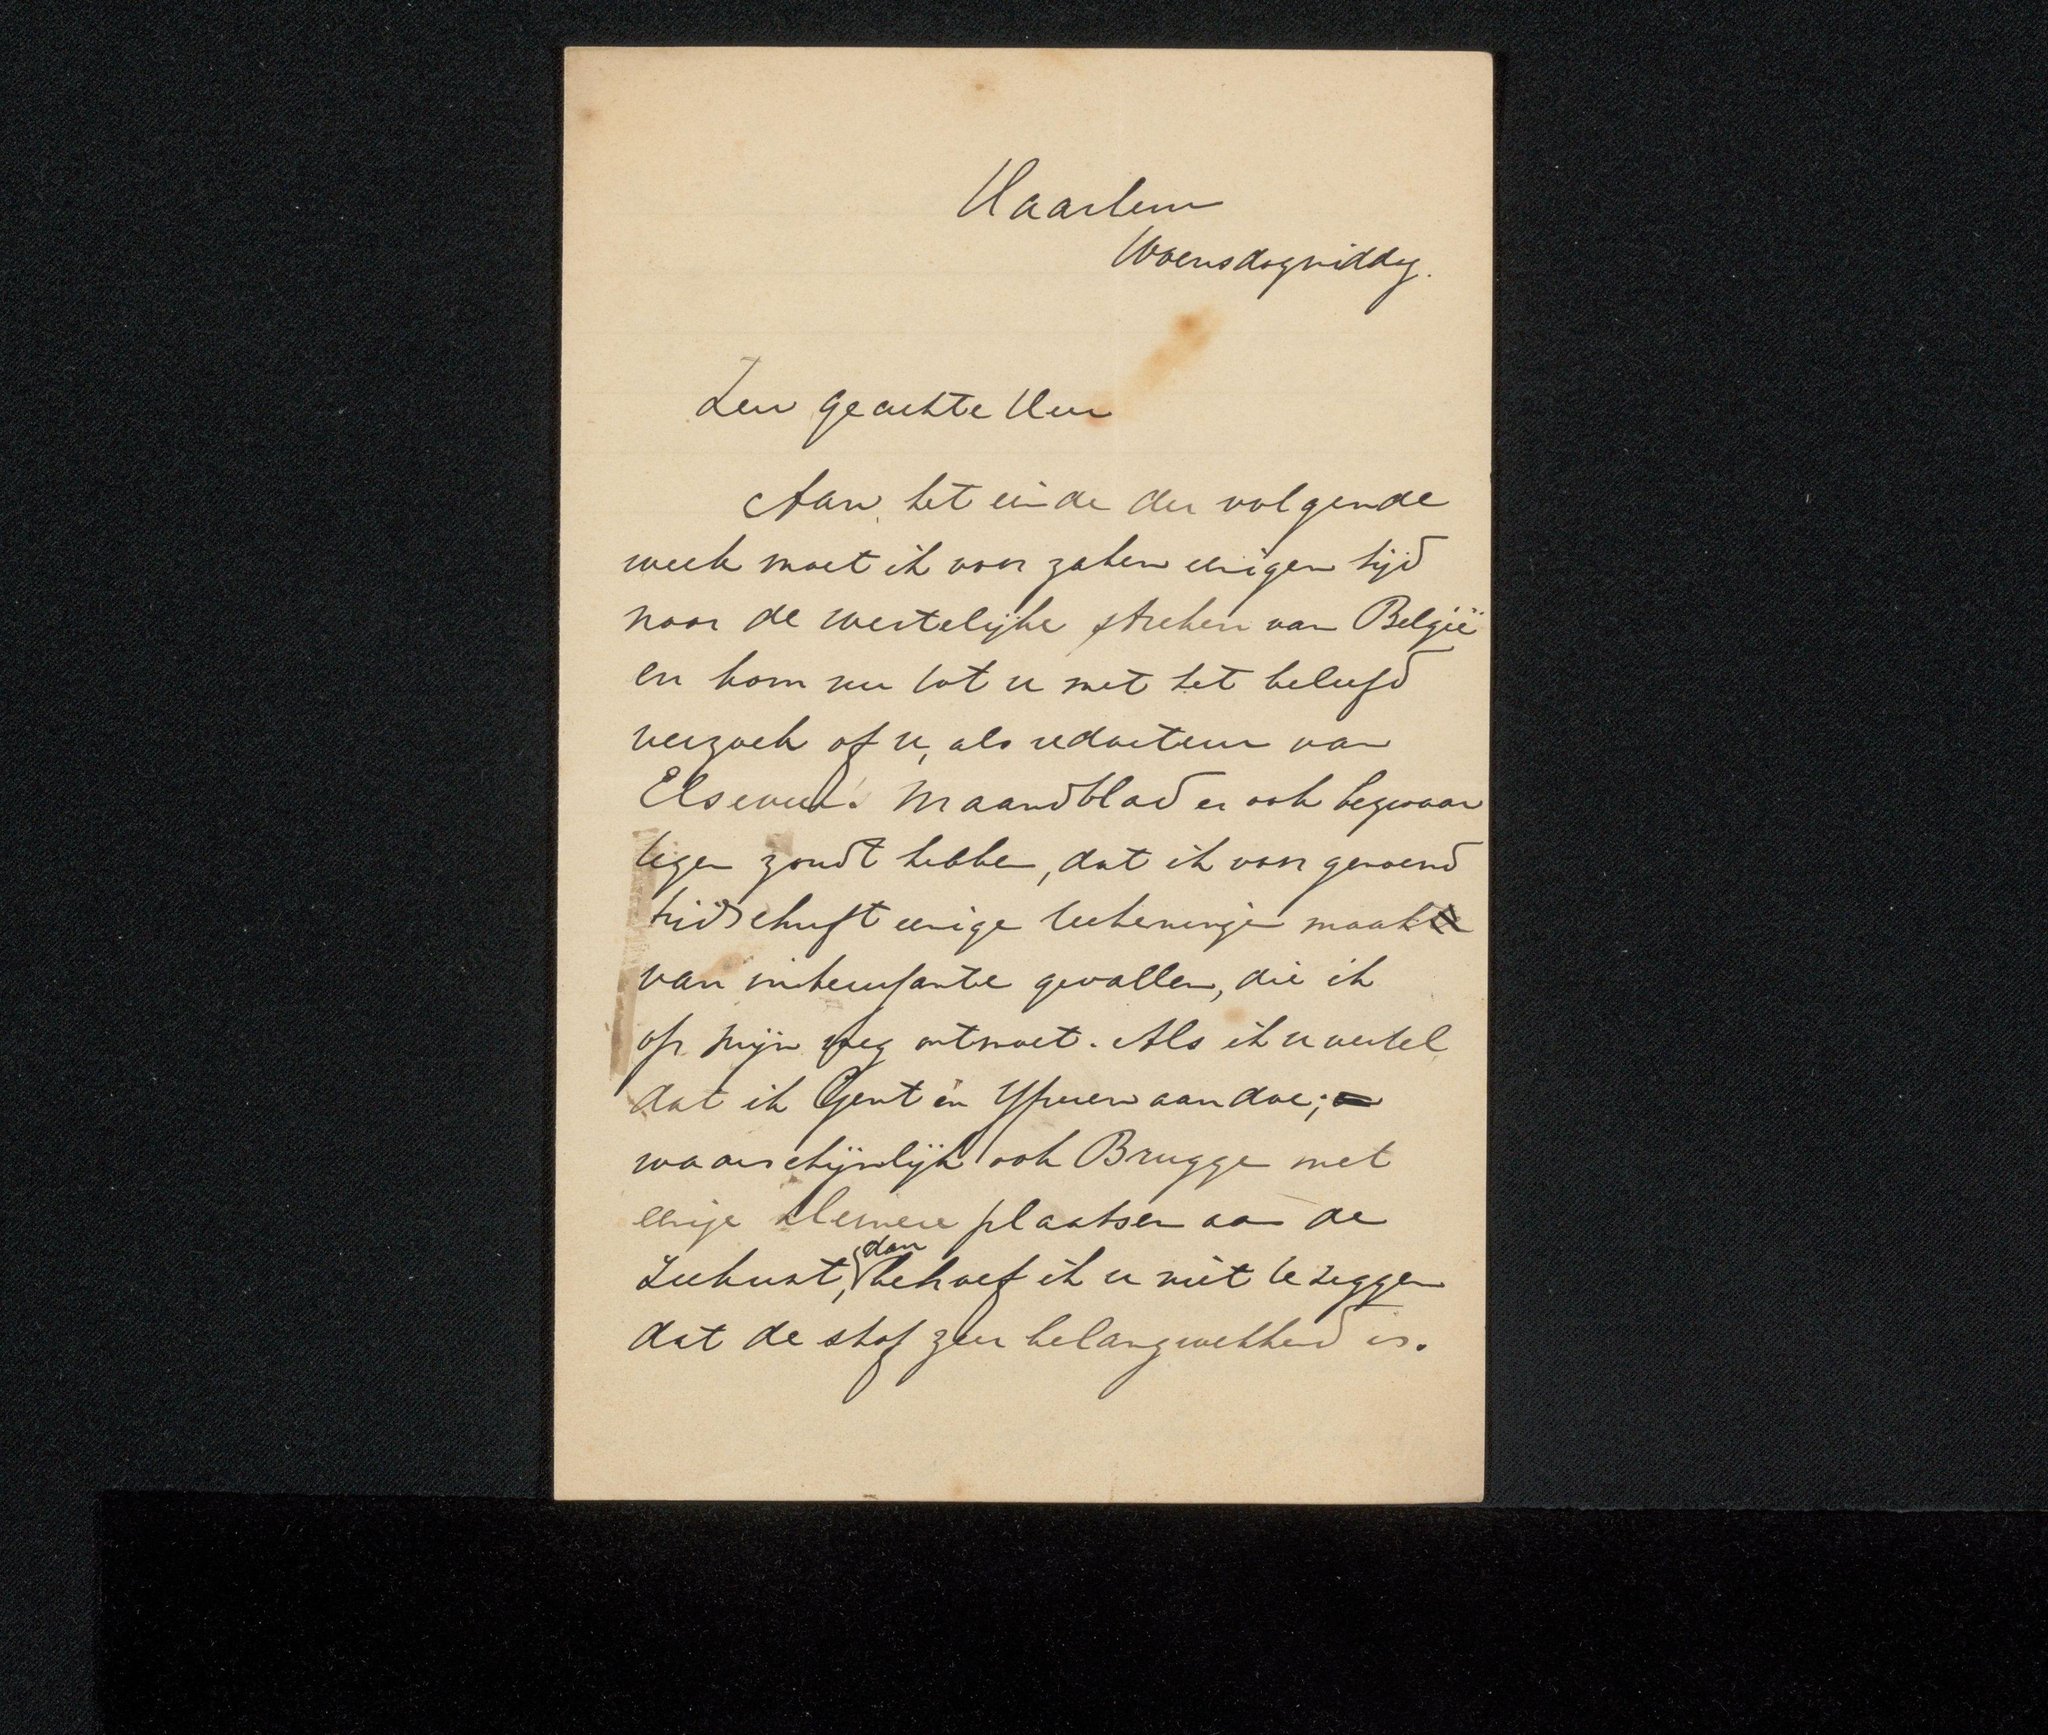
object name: letter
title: Brief aan Philip Zilcken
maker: jacobus gerardus veldheer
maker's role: draughtsman, print maker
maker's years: 1866-1954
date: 1876-1930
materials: ink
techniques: pen, writing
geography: haarlem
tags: rotterdam, amsterdam, herman robbers, the hague, painter, draughtsman, philip zilcken, drawing, ghent, bruges, belgium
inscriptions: collector's mark: ‘RPK’